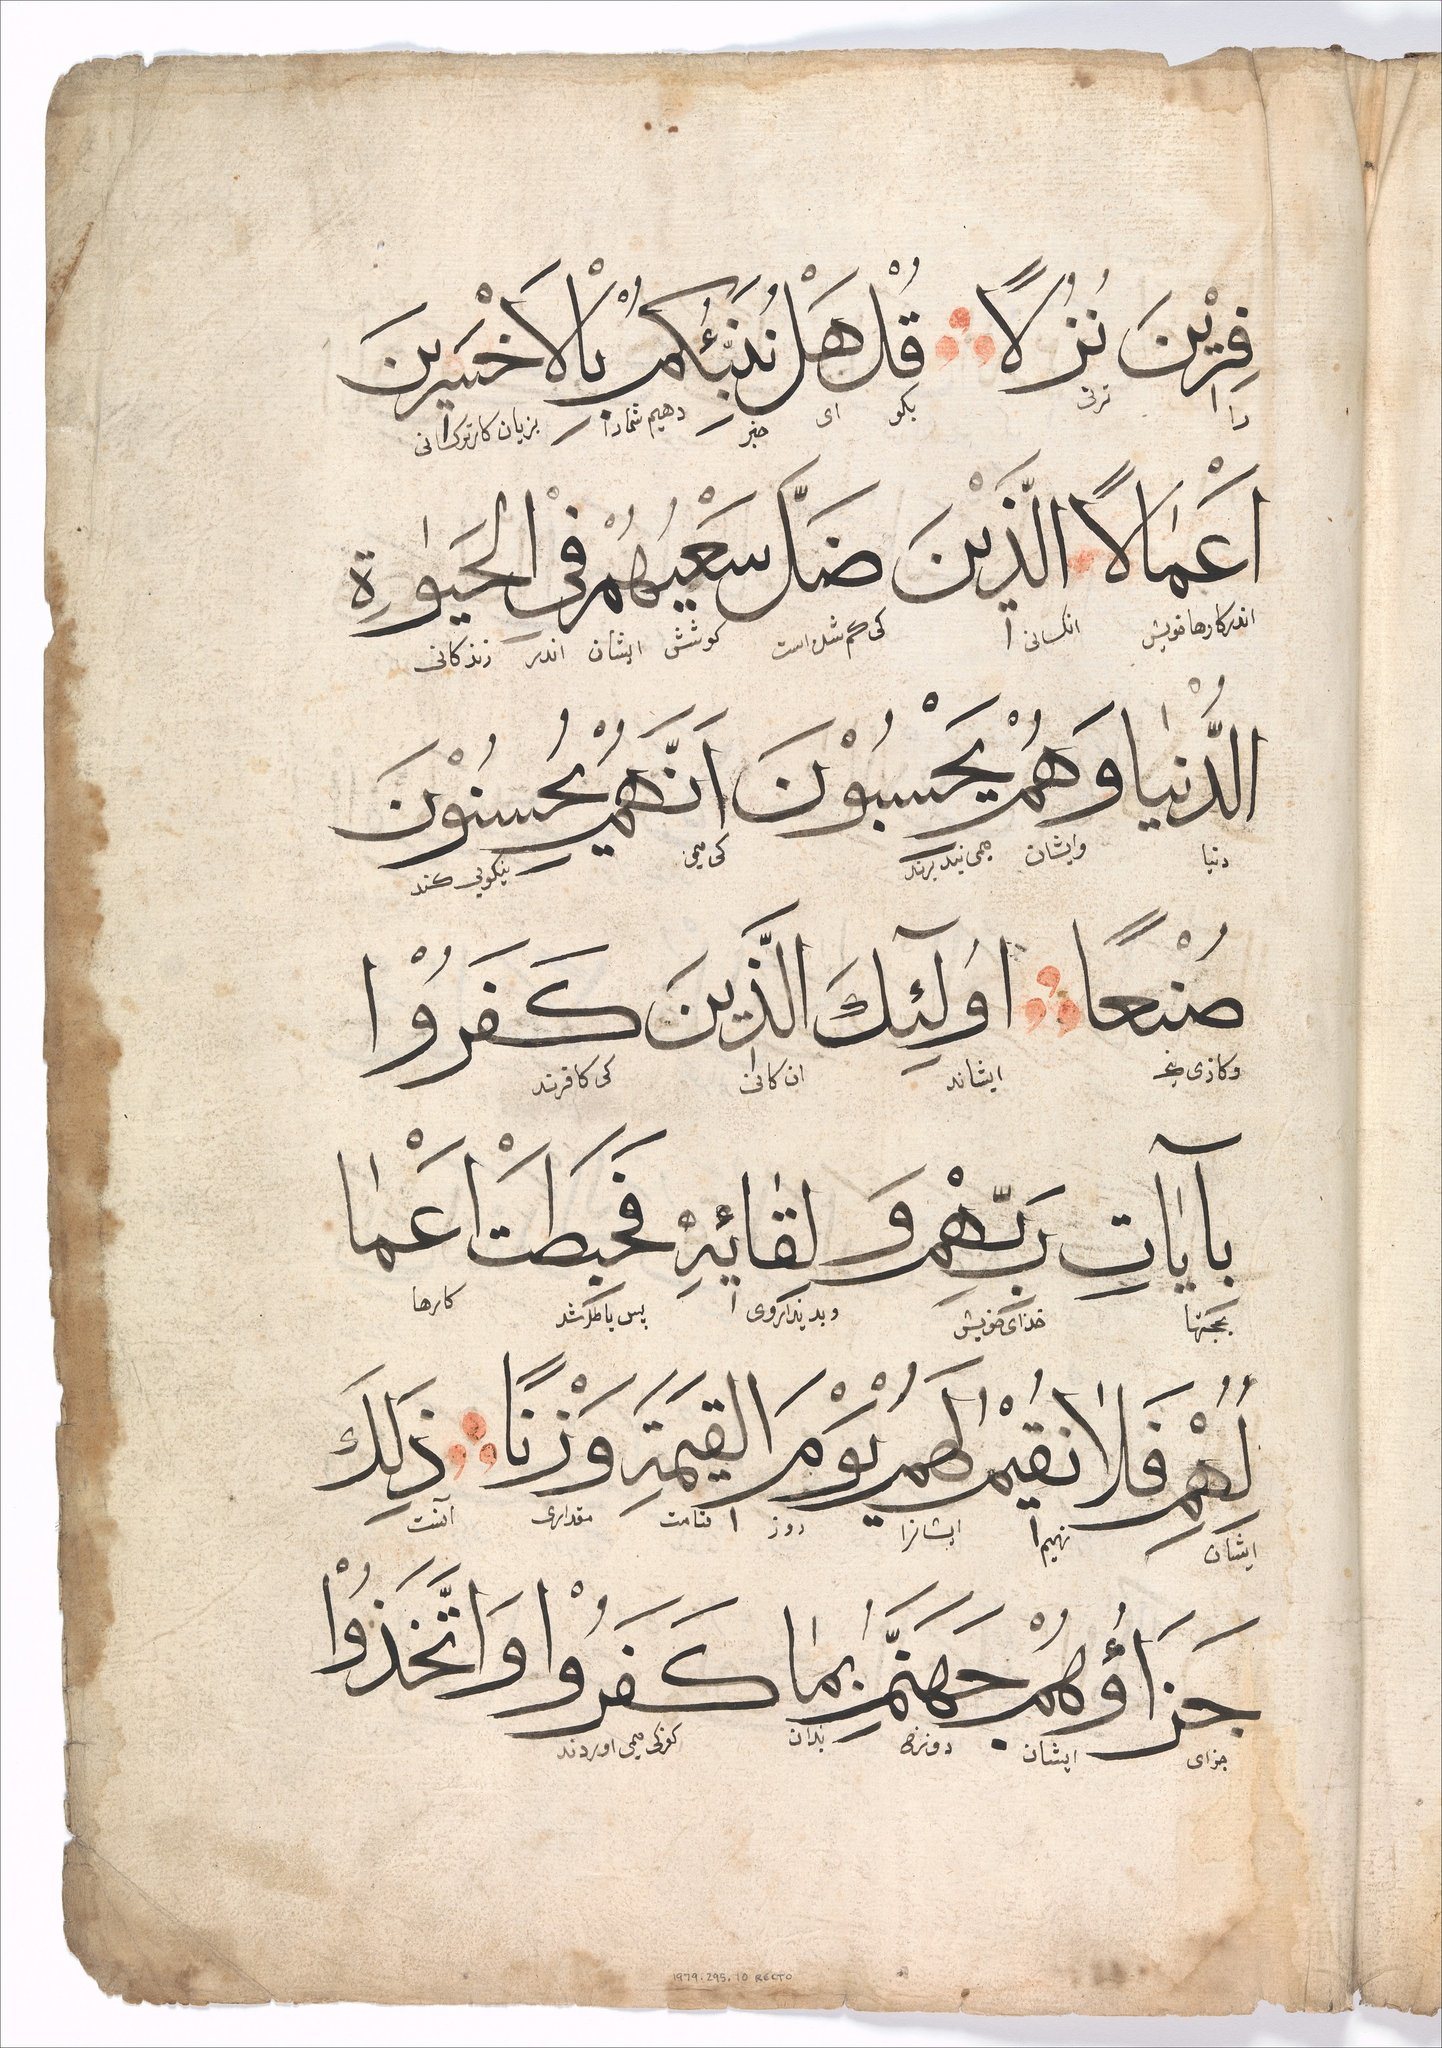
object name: folio from a non illustrated manuscript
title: Folio from a Qur'an Manuscript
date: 1301-1400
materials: ink, paper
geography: india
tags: qur'an